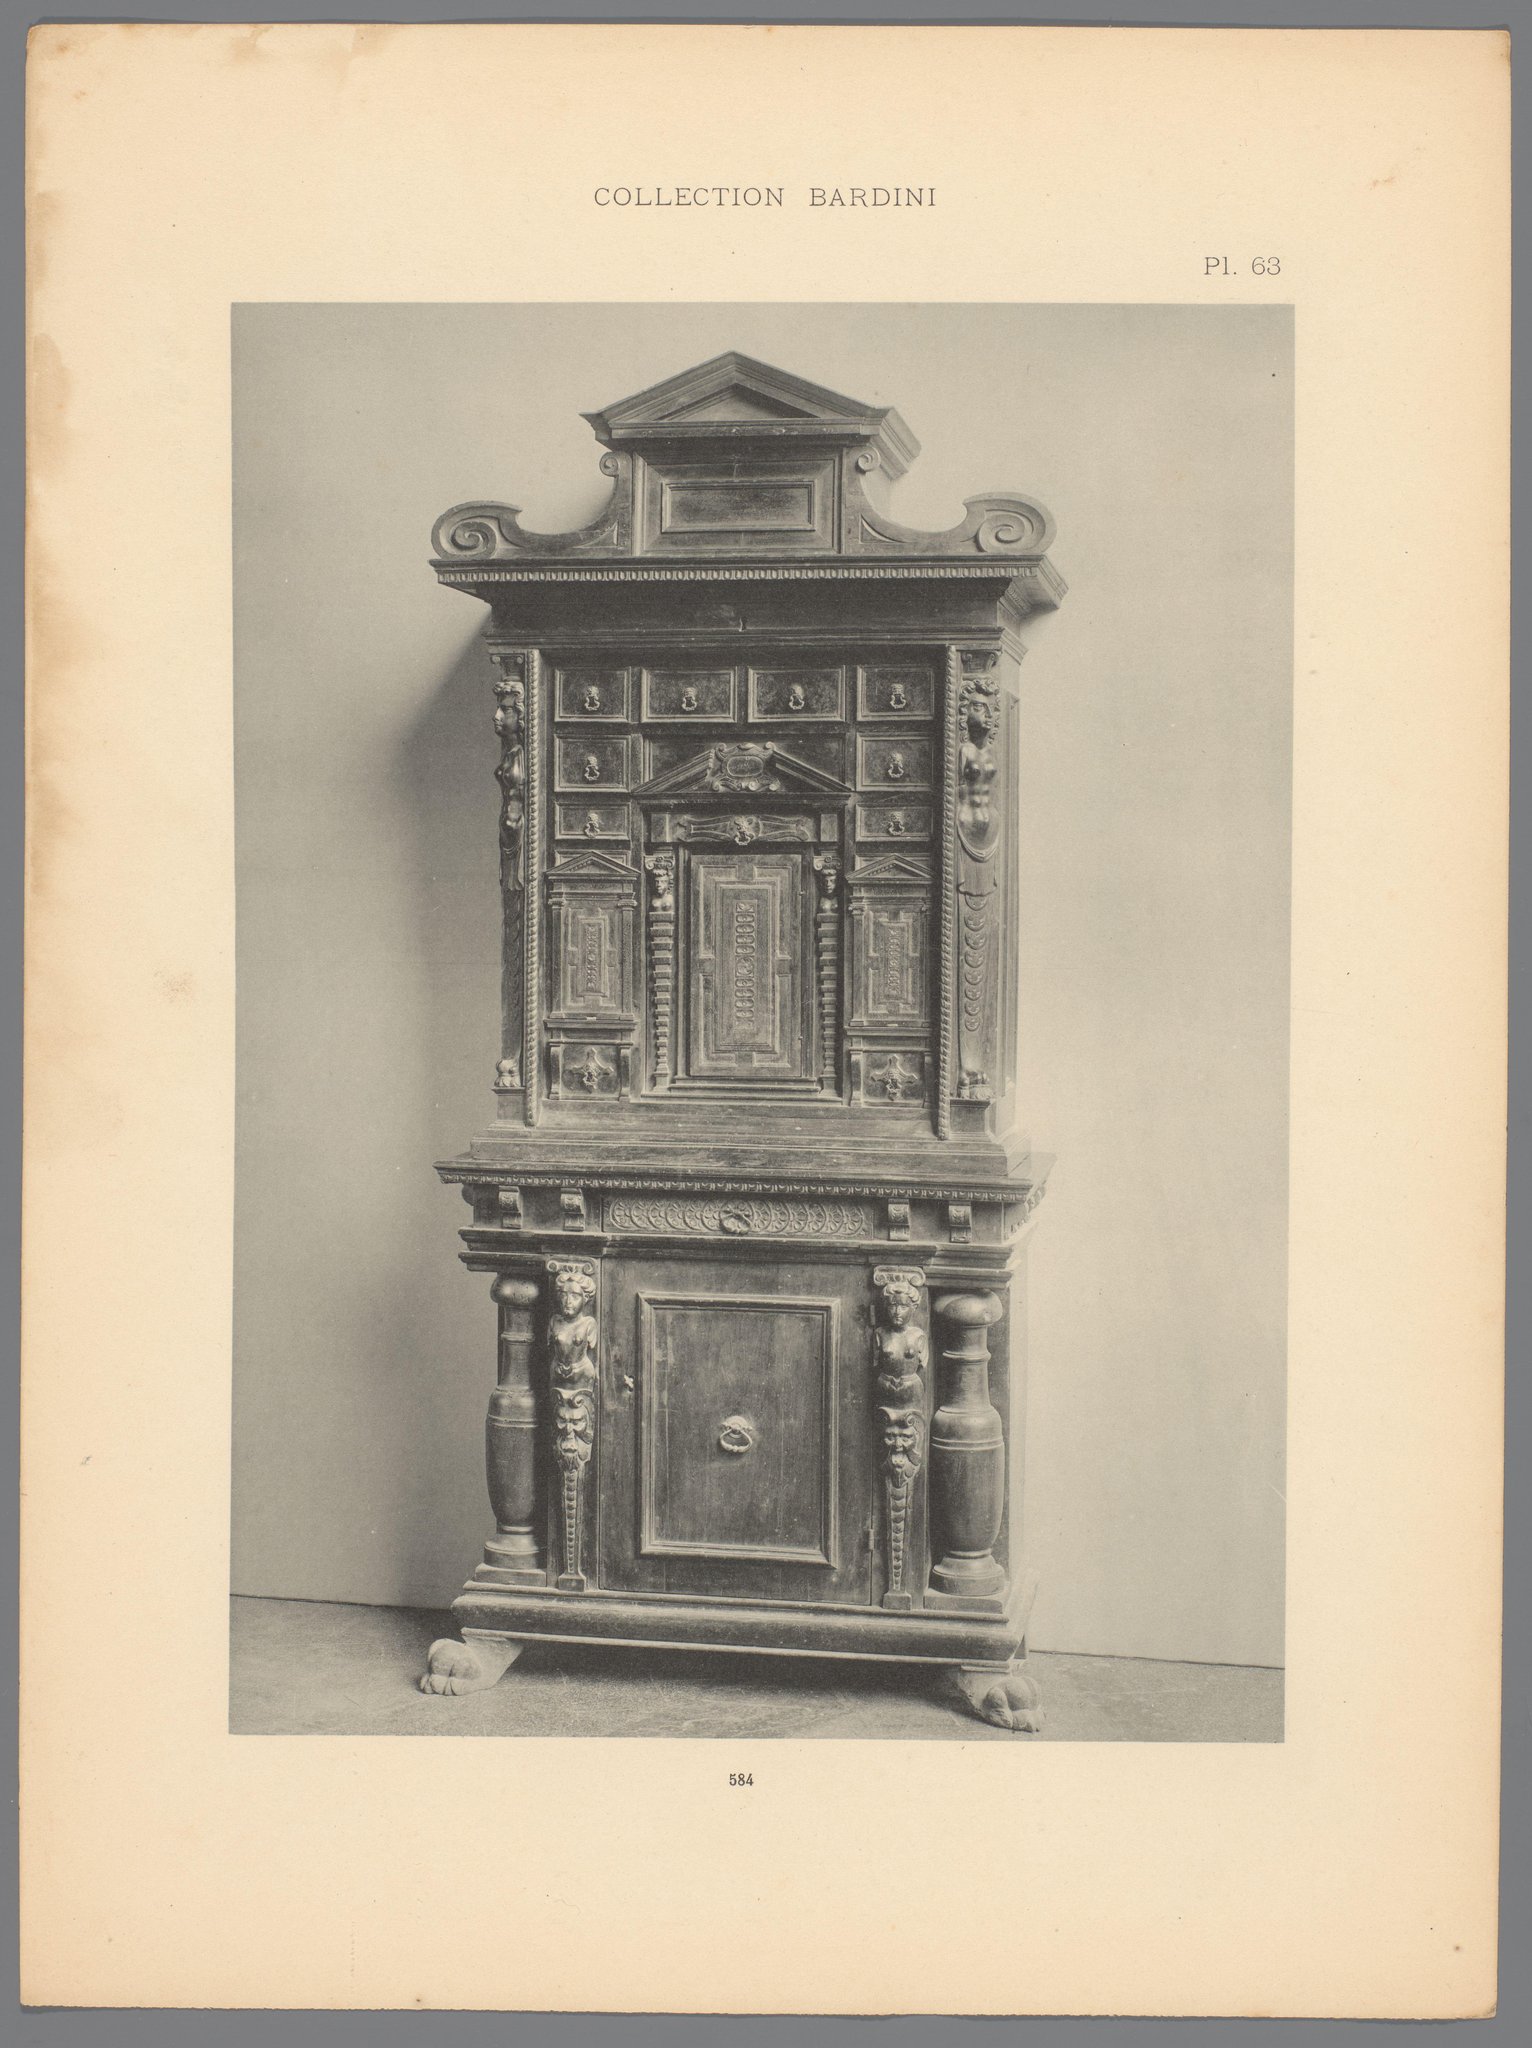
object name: photomechanical print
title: Collection Bardini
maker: Anonymous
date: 1875-1930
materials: paper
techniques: photograph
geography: florence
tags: ornamental cupboard (+ wood and other phytogenic material)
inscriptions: number: ‘Pl. 63’